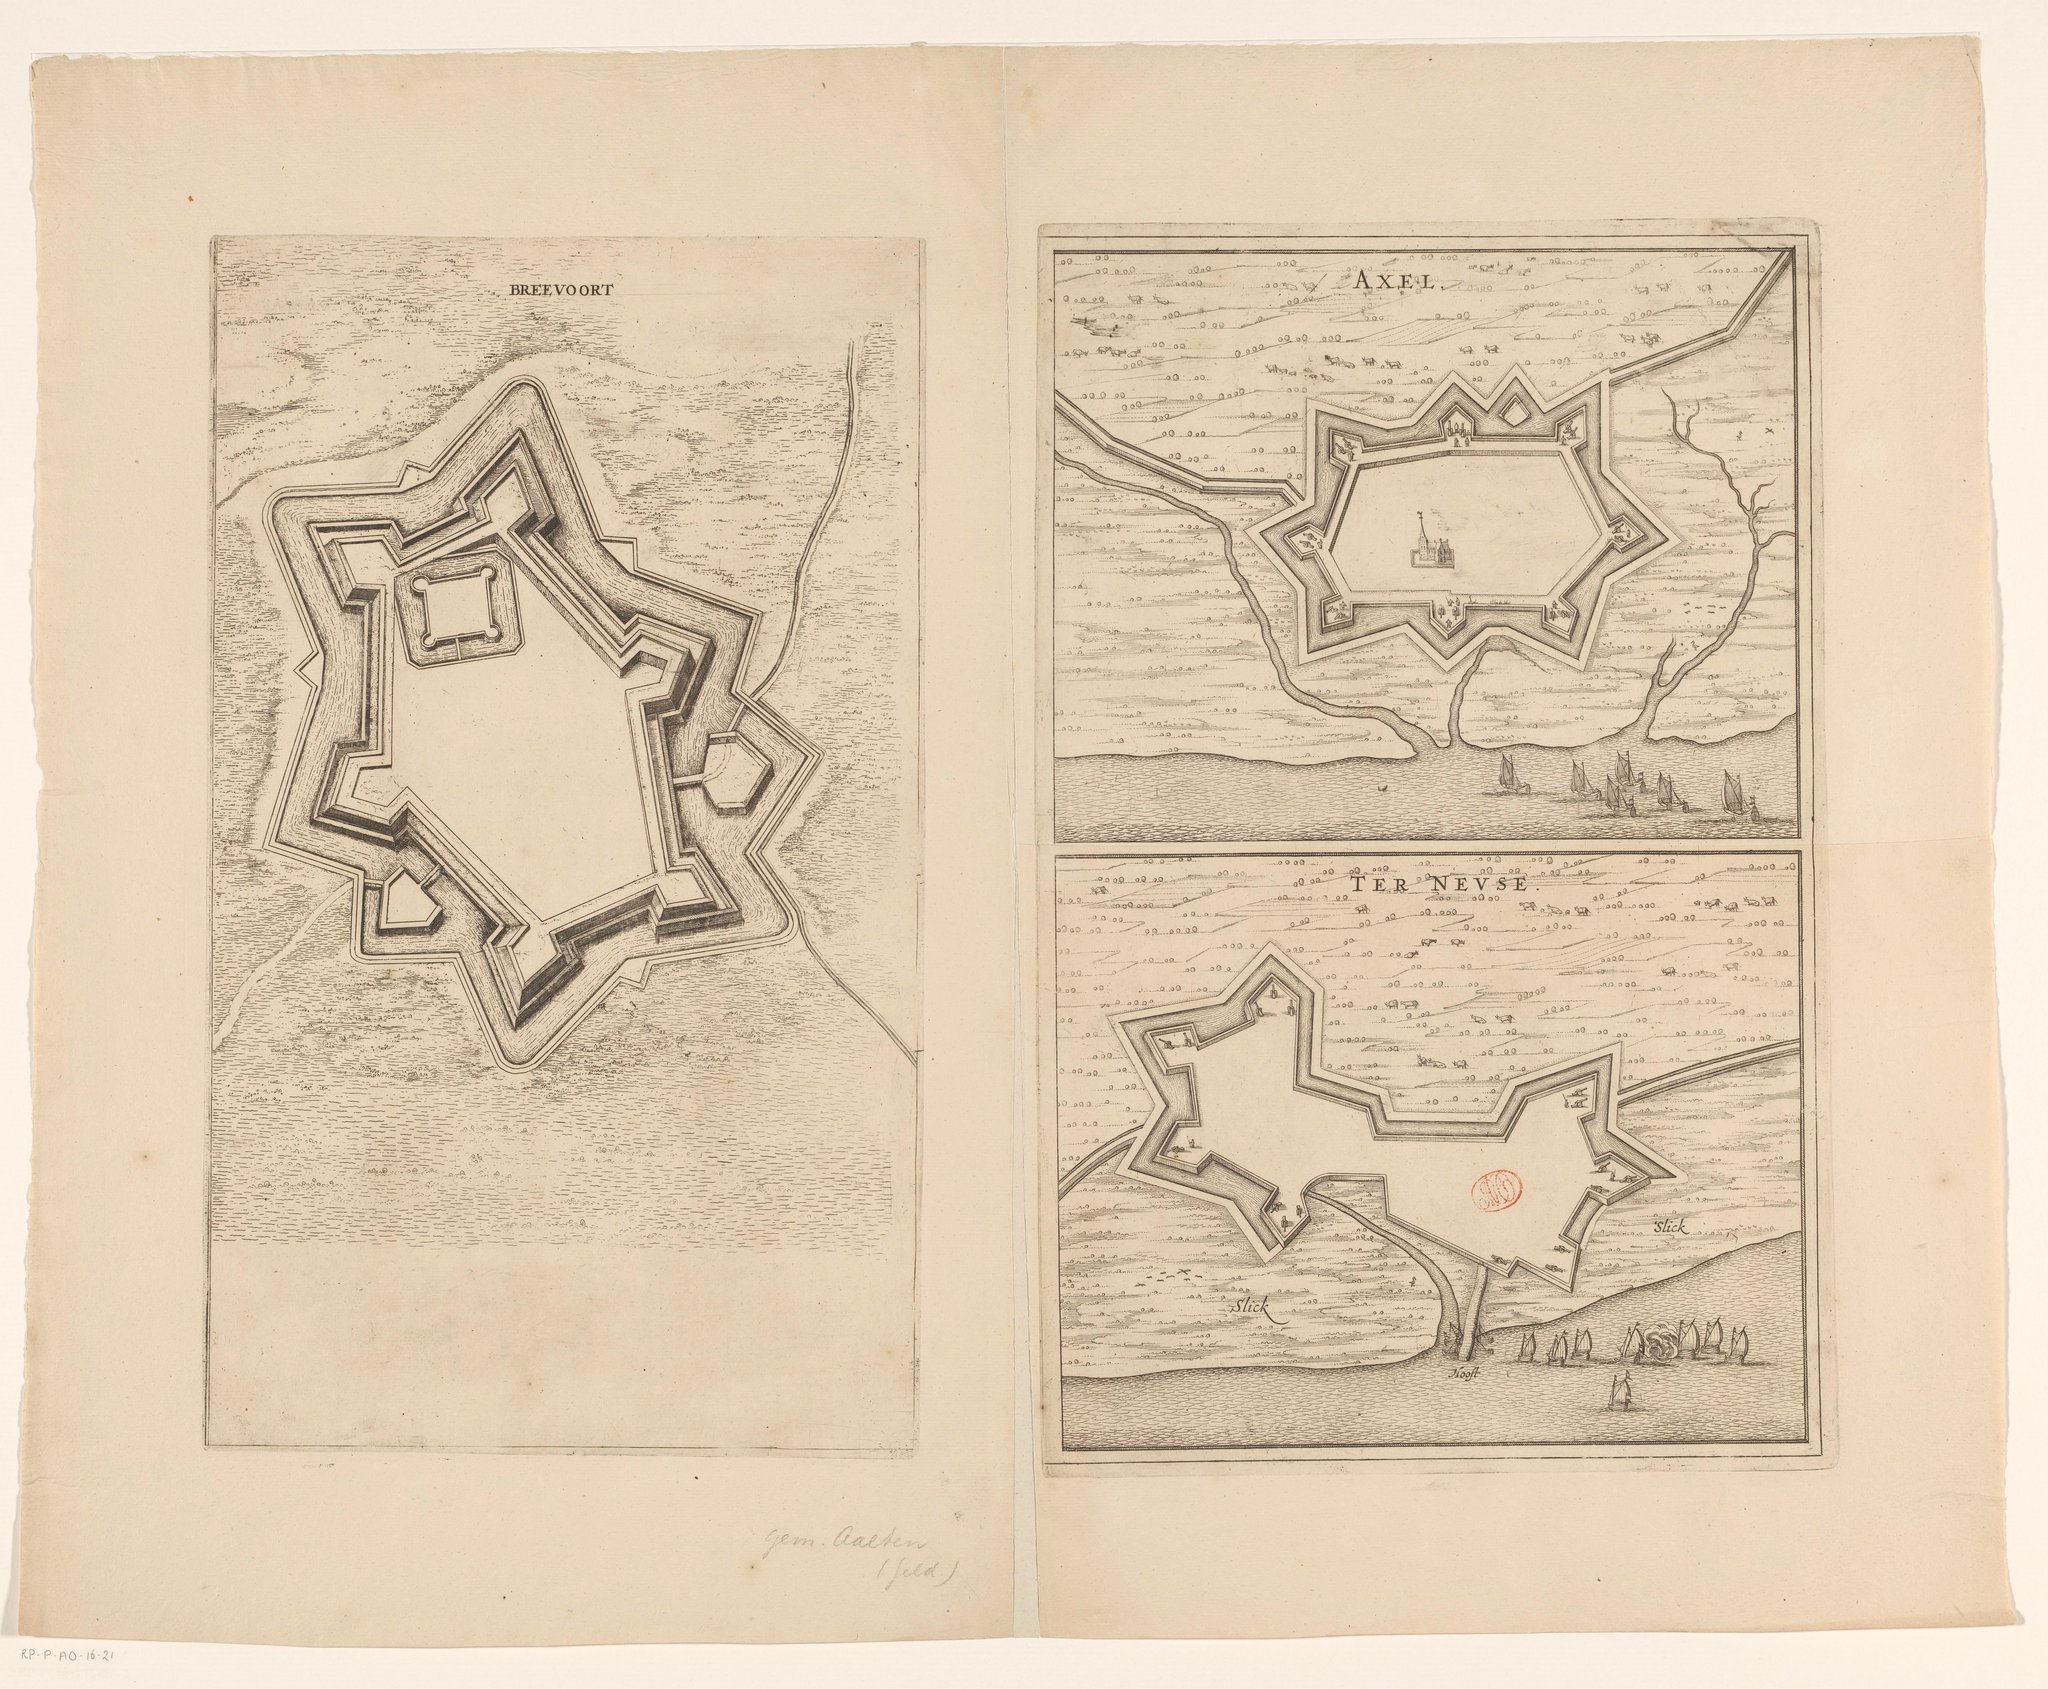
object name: area plan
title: Vestingplattegronden van Bredevoort, Axel en Terneuzen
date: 1652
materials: paper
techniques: engraving, etching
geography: amsterdam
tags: fortified city, maps of cities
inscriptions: collector's mark: Lugt 195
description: Rechterplaat is eerder verschenen in Stedenboeken van Blaeu (1652), linkerplaat is echter een kopie van Blaeu’s vestingplattegrond van Bredevoort. In Blaeu’s Stedenboeken zijn de plattegronden van deze plaatsen ook nooit op hetzelfde blad gedrukt. Bekend is dat Frederik de Wit aan het einde van de zeventiende eeuw een groot deel van de platen van Blaeu verwierf, die hij hergebruikte in zijn stedenatlassen. Deze atlassen hadden een wisselende samenstelling. De huidige samenstelling is niet terug te vinden in literatuur, maar gezien de wisselende aard van De Wits atlassen zou het mogelijk kunnen zijn dat hij de uitgever is van dit blad.